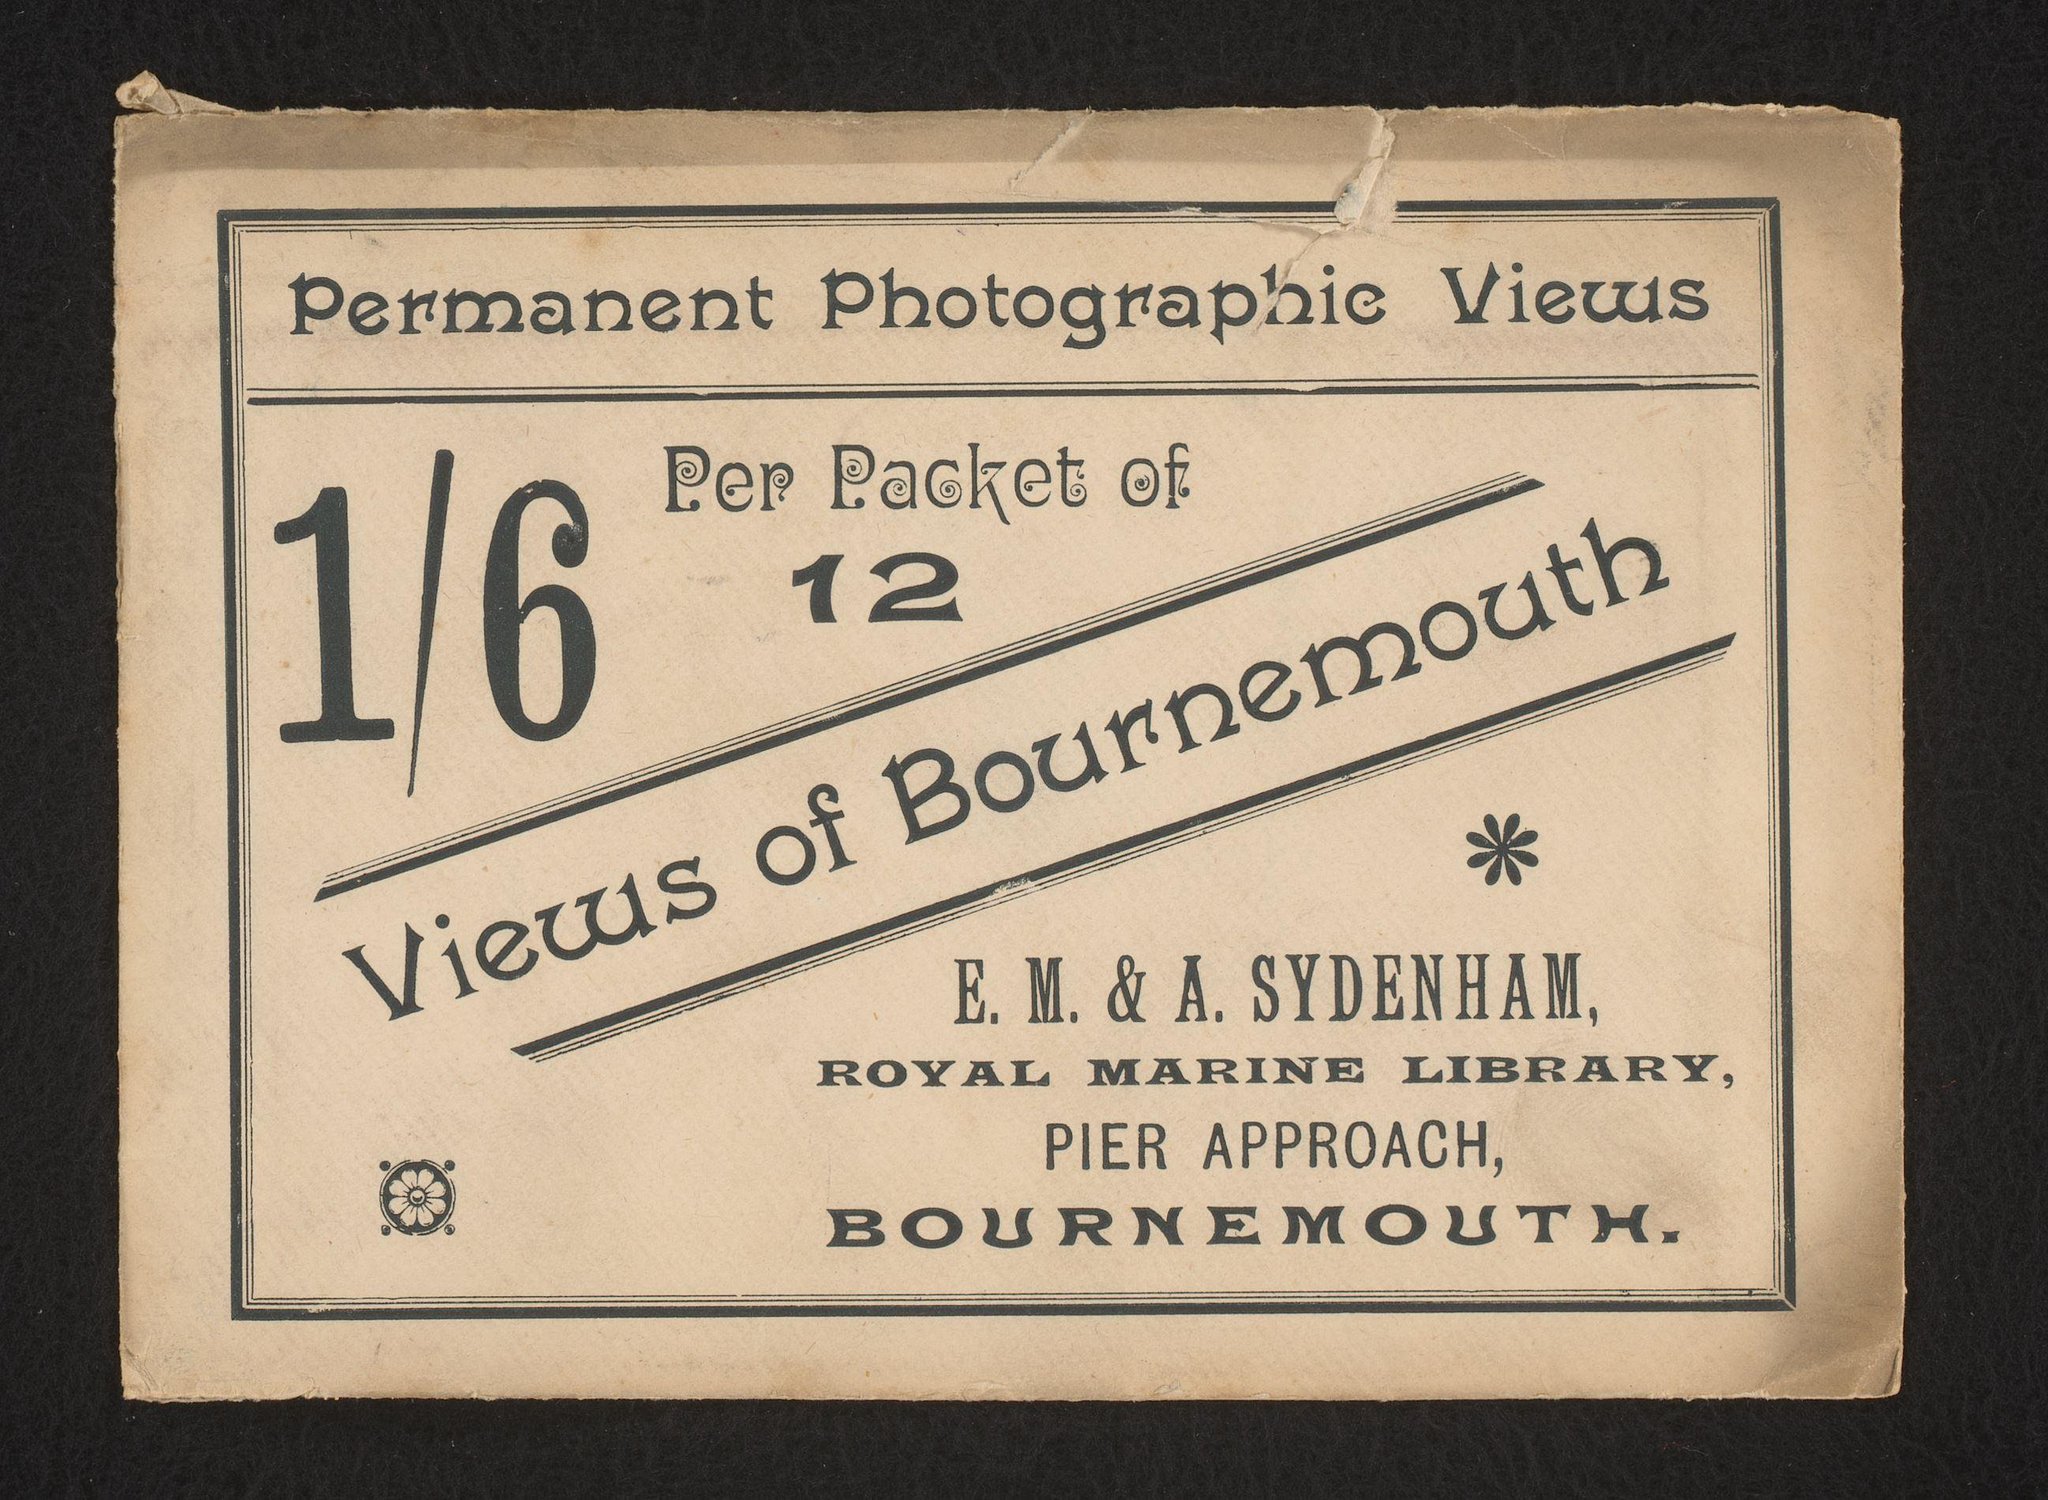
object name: envelope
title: Views of Bournemouth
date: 1900-1930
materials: paper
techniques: photograph, printing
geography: bournemouth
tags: forest path or lane, pier, quay, wharf, prospect of city, town panorama, silhouette of city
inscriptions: inscription: ‘Permanent Photographie Views/ 1/6/ Per Packet of/ 12/ Views of Bournemouth/ E. M. & A. SYDENHAM,/ ROYAL MARINE LIBRARY,/ PIER APPROACH,/ BOURNEMOUTH.’, collector's mark: ‘DIENST/ VERSPREIDE/ RIJKSKOLLEKTIES/ (...) A 962’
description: Envelop met twaalf prenten van plaatsen in de regio Bournemouth. Afgebeeld zijn onder andere Branscombe, de wijk Boscombe en de pier.